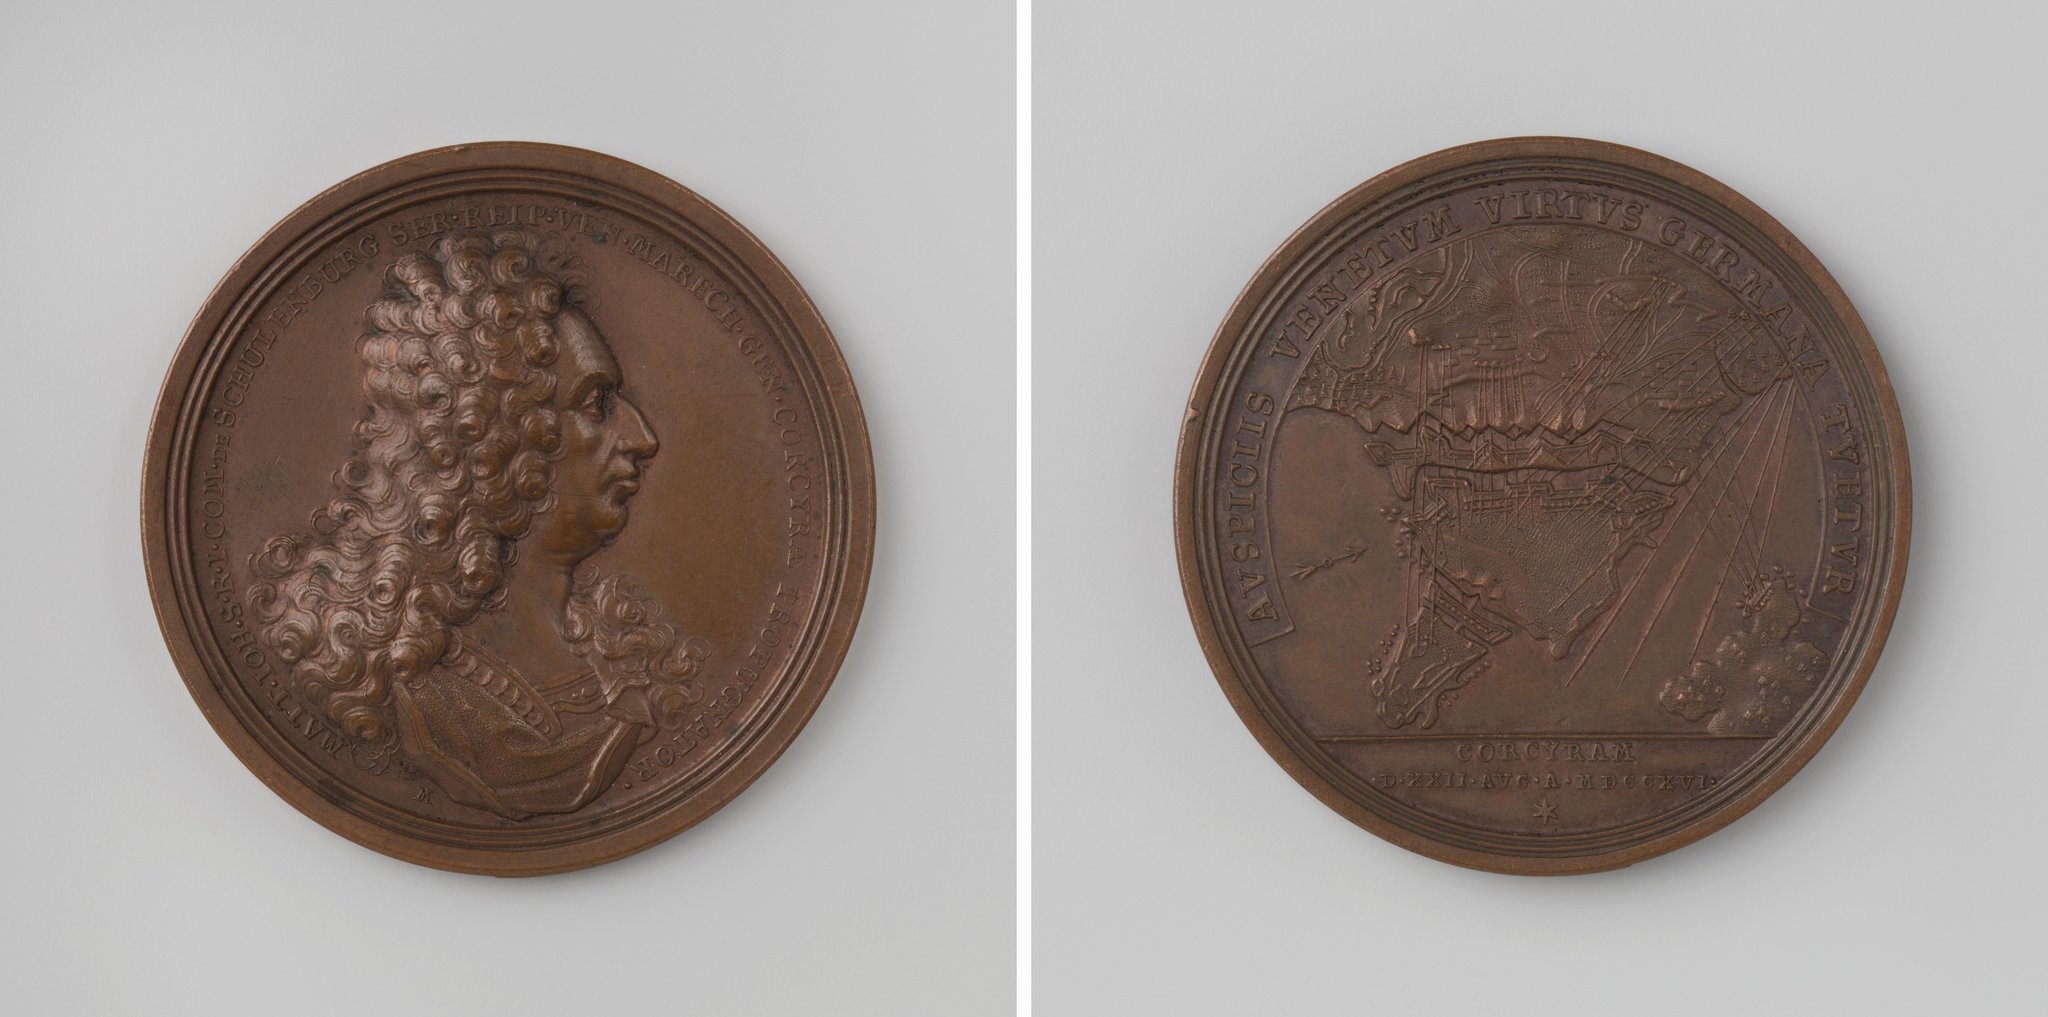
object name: history medal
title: Verdediging van Corcyra door Mattheus Johannes, graaf van Schulenburg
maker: philipp heinrich müller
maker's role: medailleur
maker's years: 1654-1719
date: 1716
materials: bronze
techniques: striking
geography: nuremberg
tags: emden, verona, militair, matthias johann von der schulenburg, griekenland, korfoe, oorlog tegen de turken (1716-1718), verdediging van corcyra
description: Bronzen penning. Voorzijde: borststuk man binnen omschrift. Keerzijde: plattegrond van Corcyra binnen omschrift; afsnede: opschrift